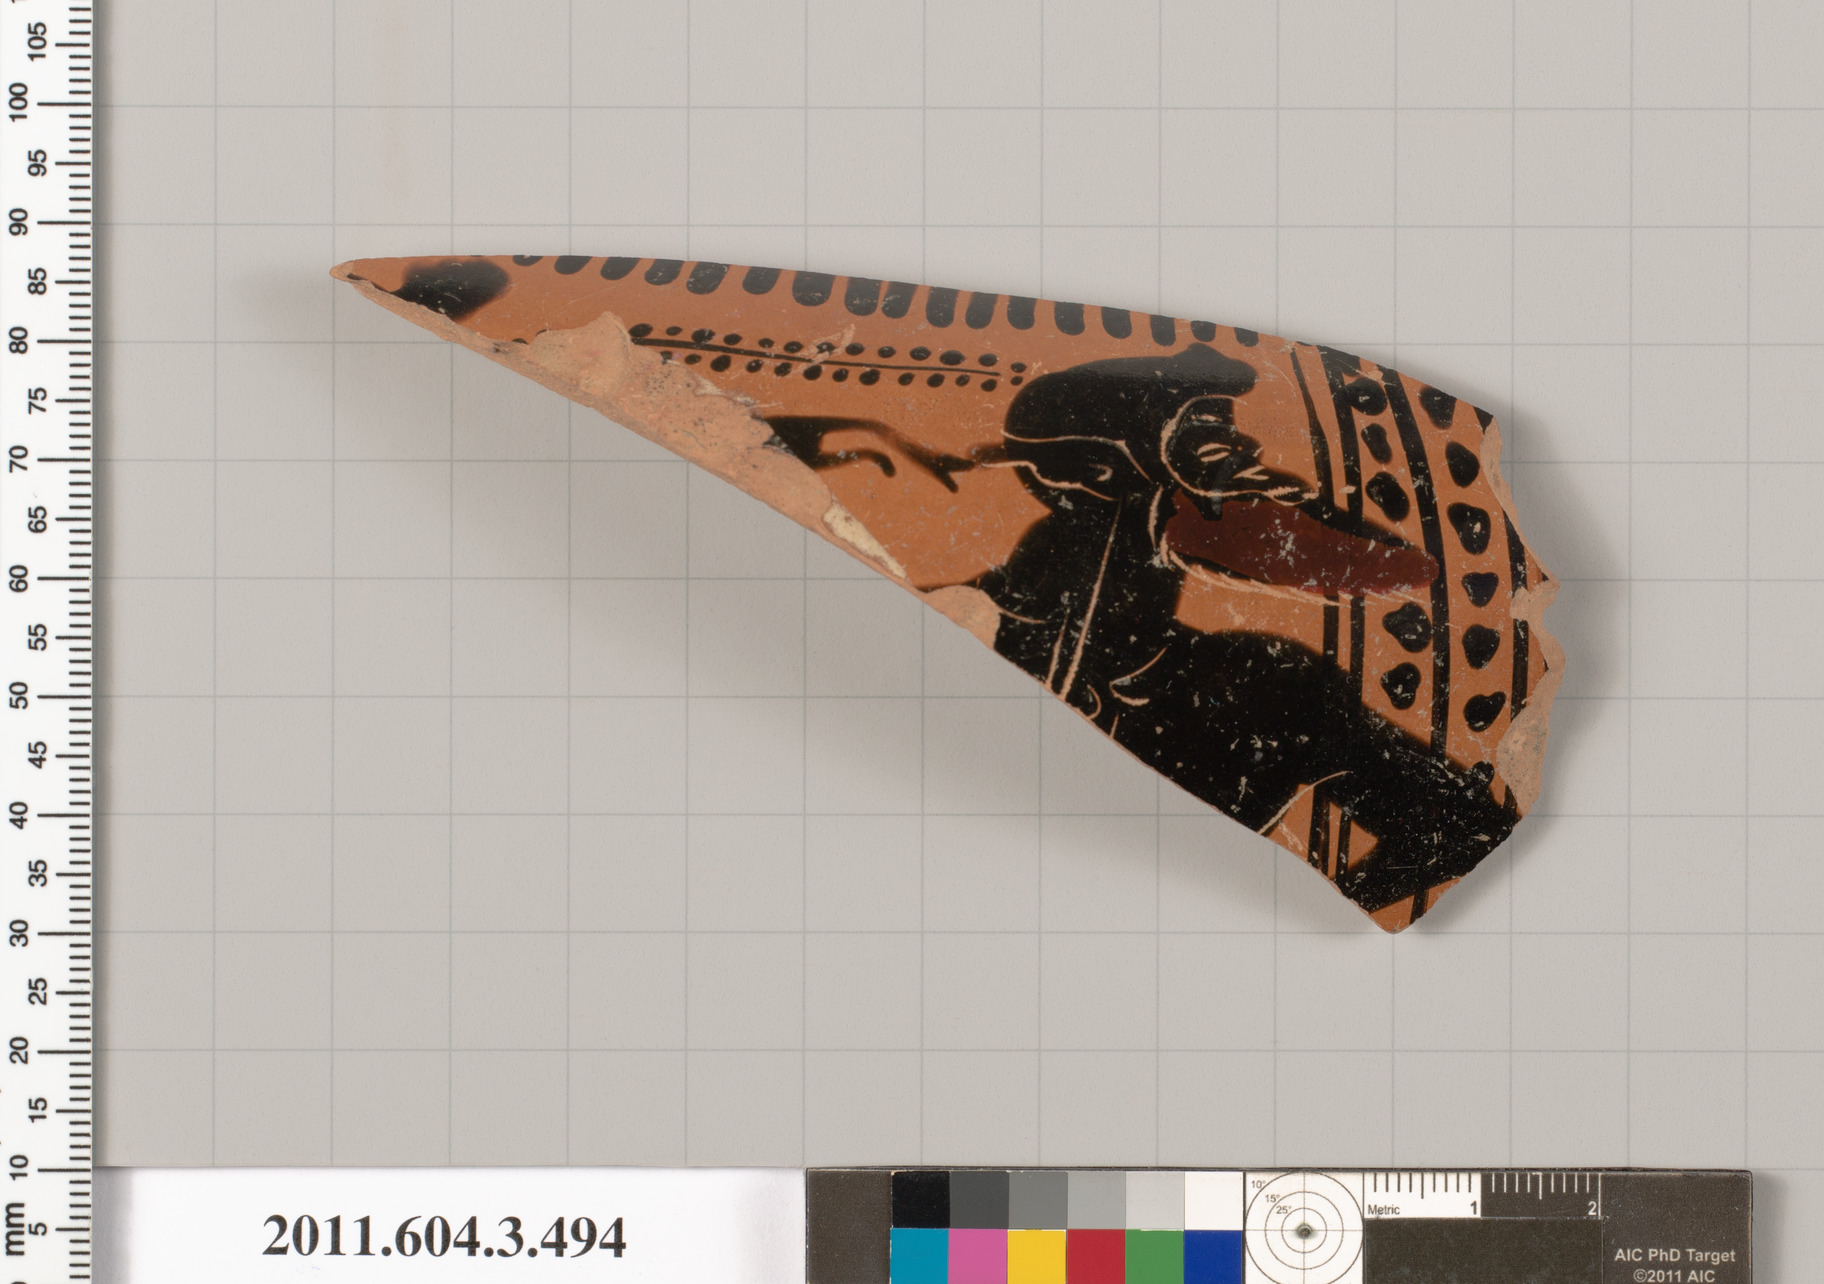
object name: column krater fragment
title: Terracotta fragment of a column-krater (bowl for mixing wine and water)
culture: greek, attic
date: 550-526 BCE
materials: terracotta